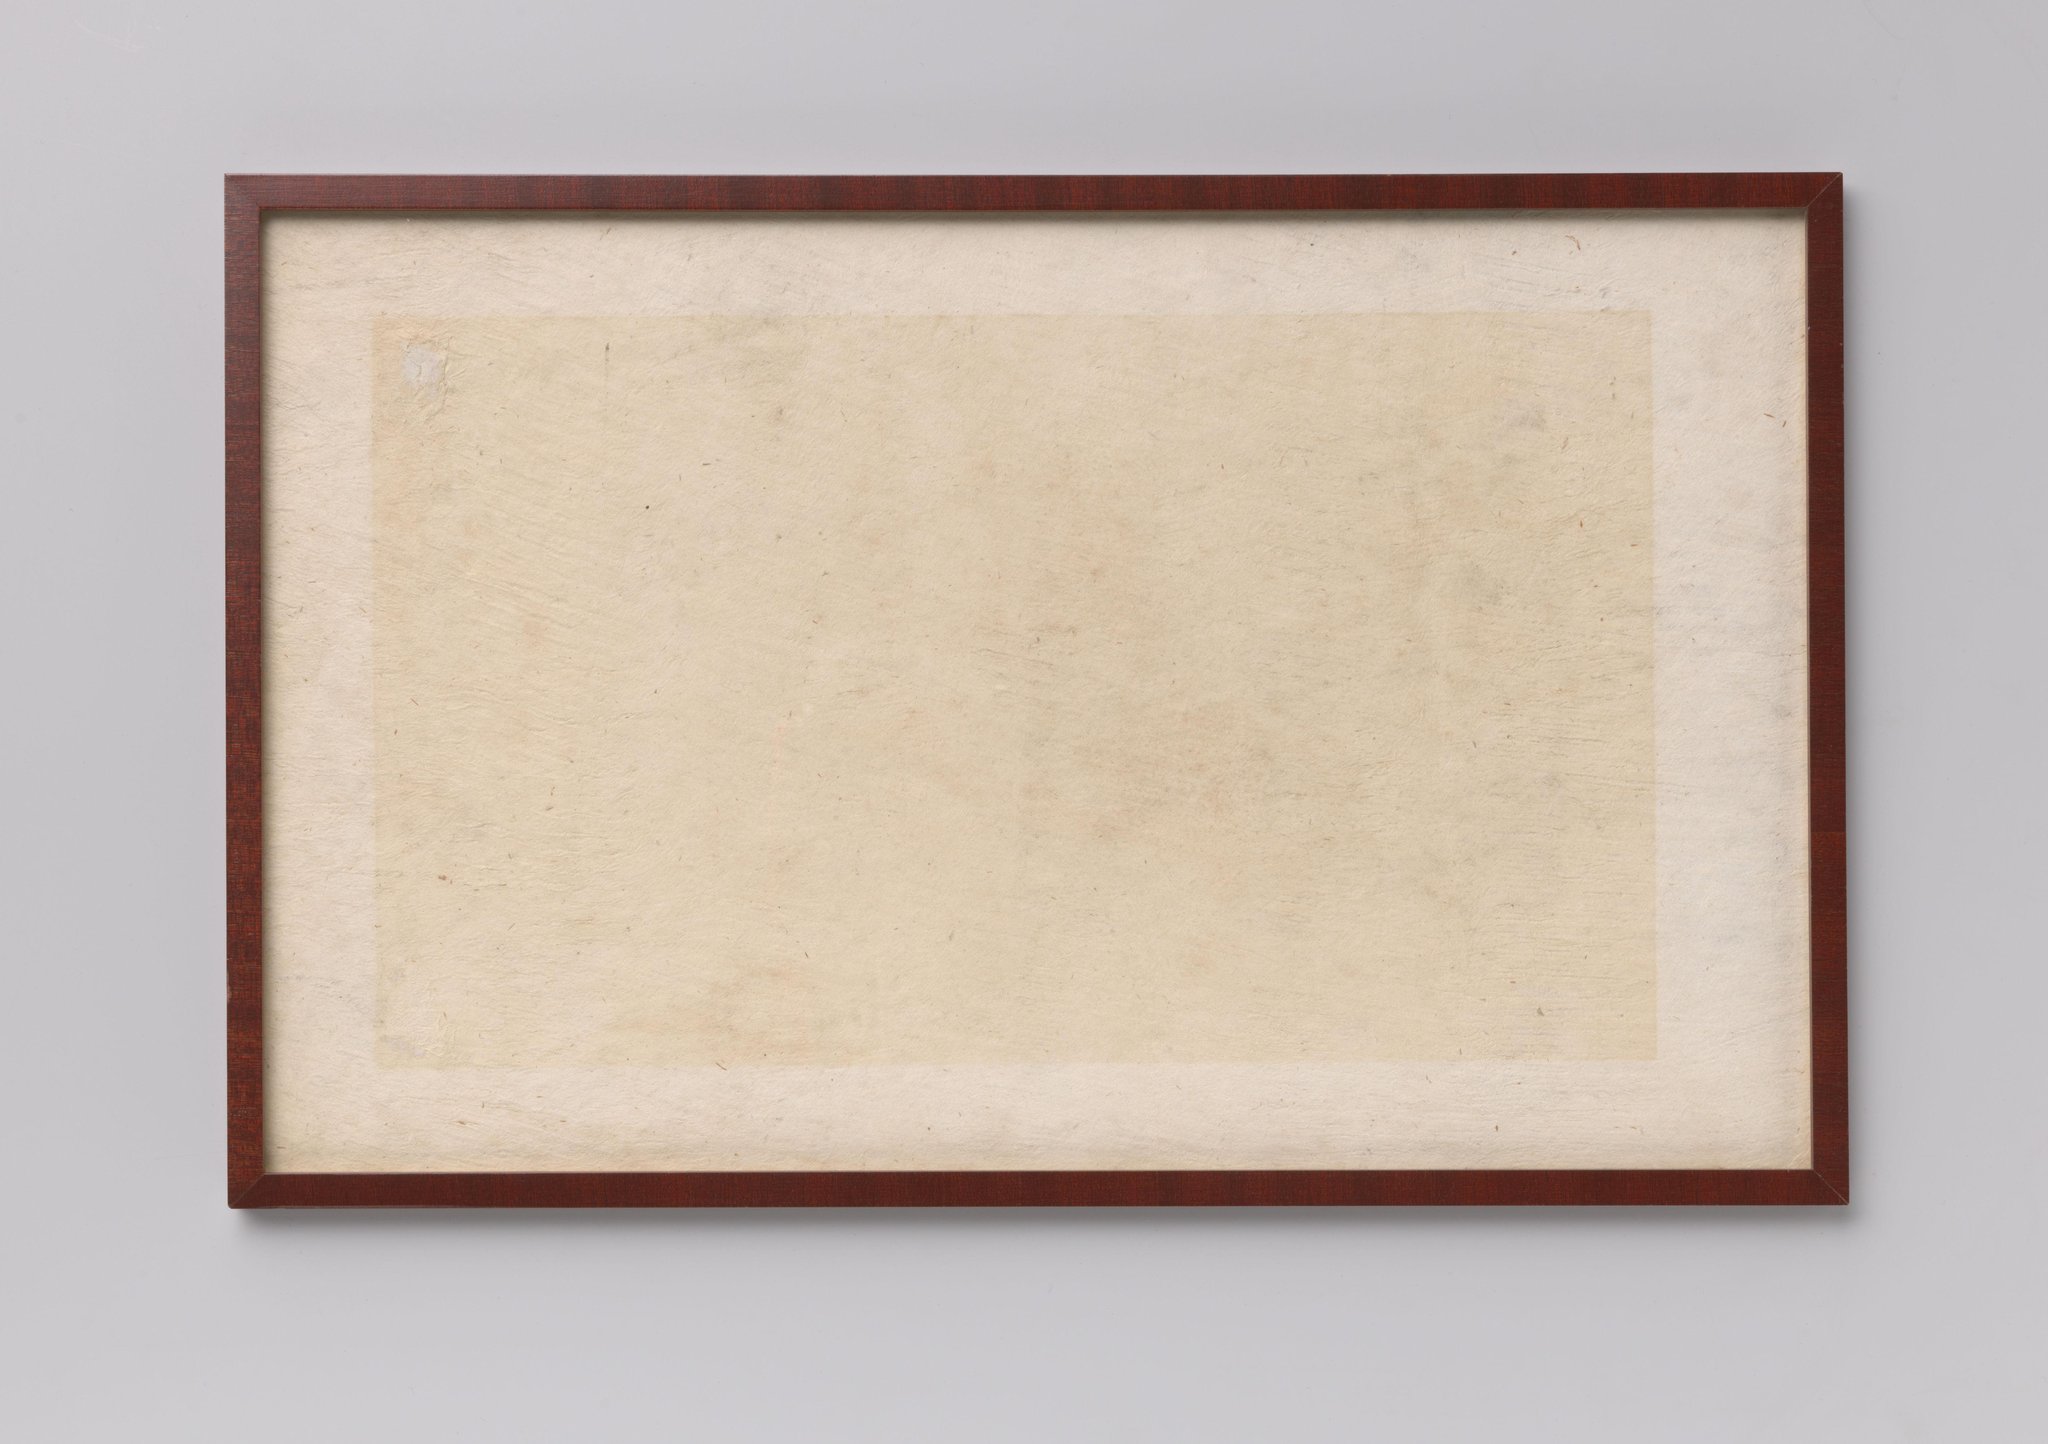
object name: frame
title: Picture Frame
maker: Anonymous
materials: glass, wood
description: Lijst voor tekening met titel "Aronskelk".